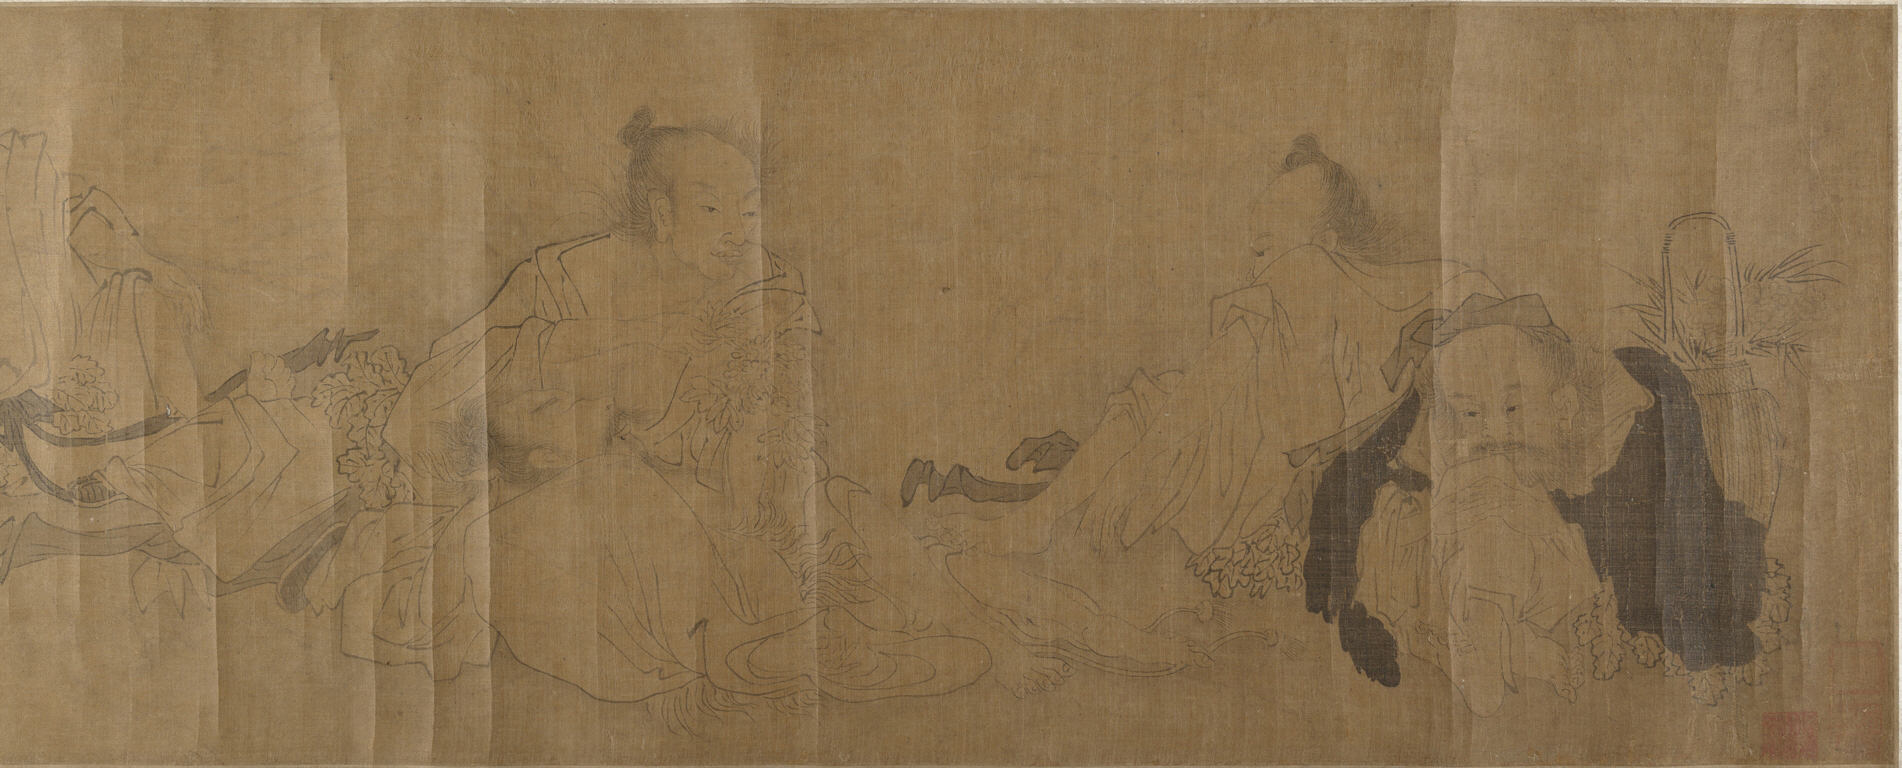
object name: handscroll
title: Immortals and Sages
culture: chinese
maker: unidentified artist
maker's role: artist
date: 1368-1644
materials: ink, silk